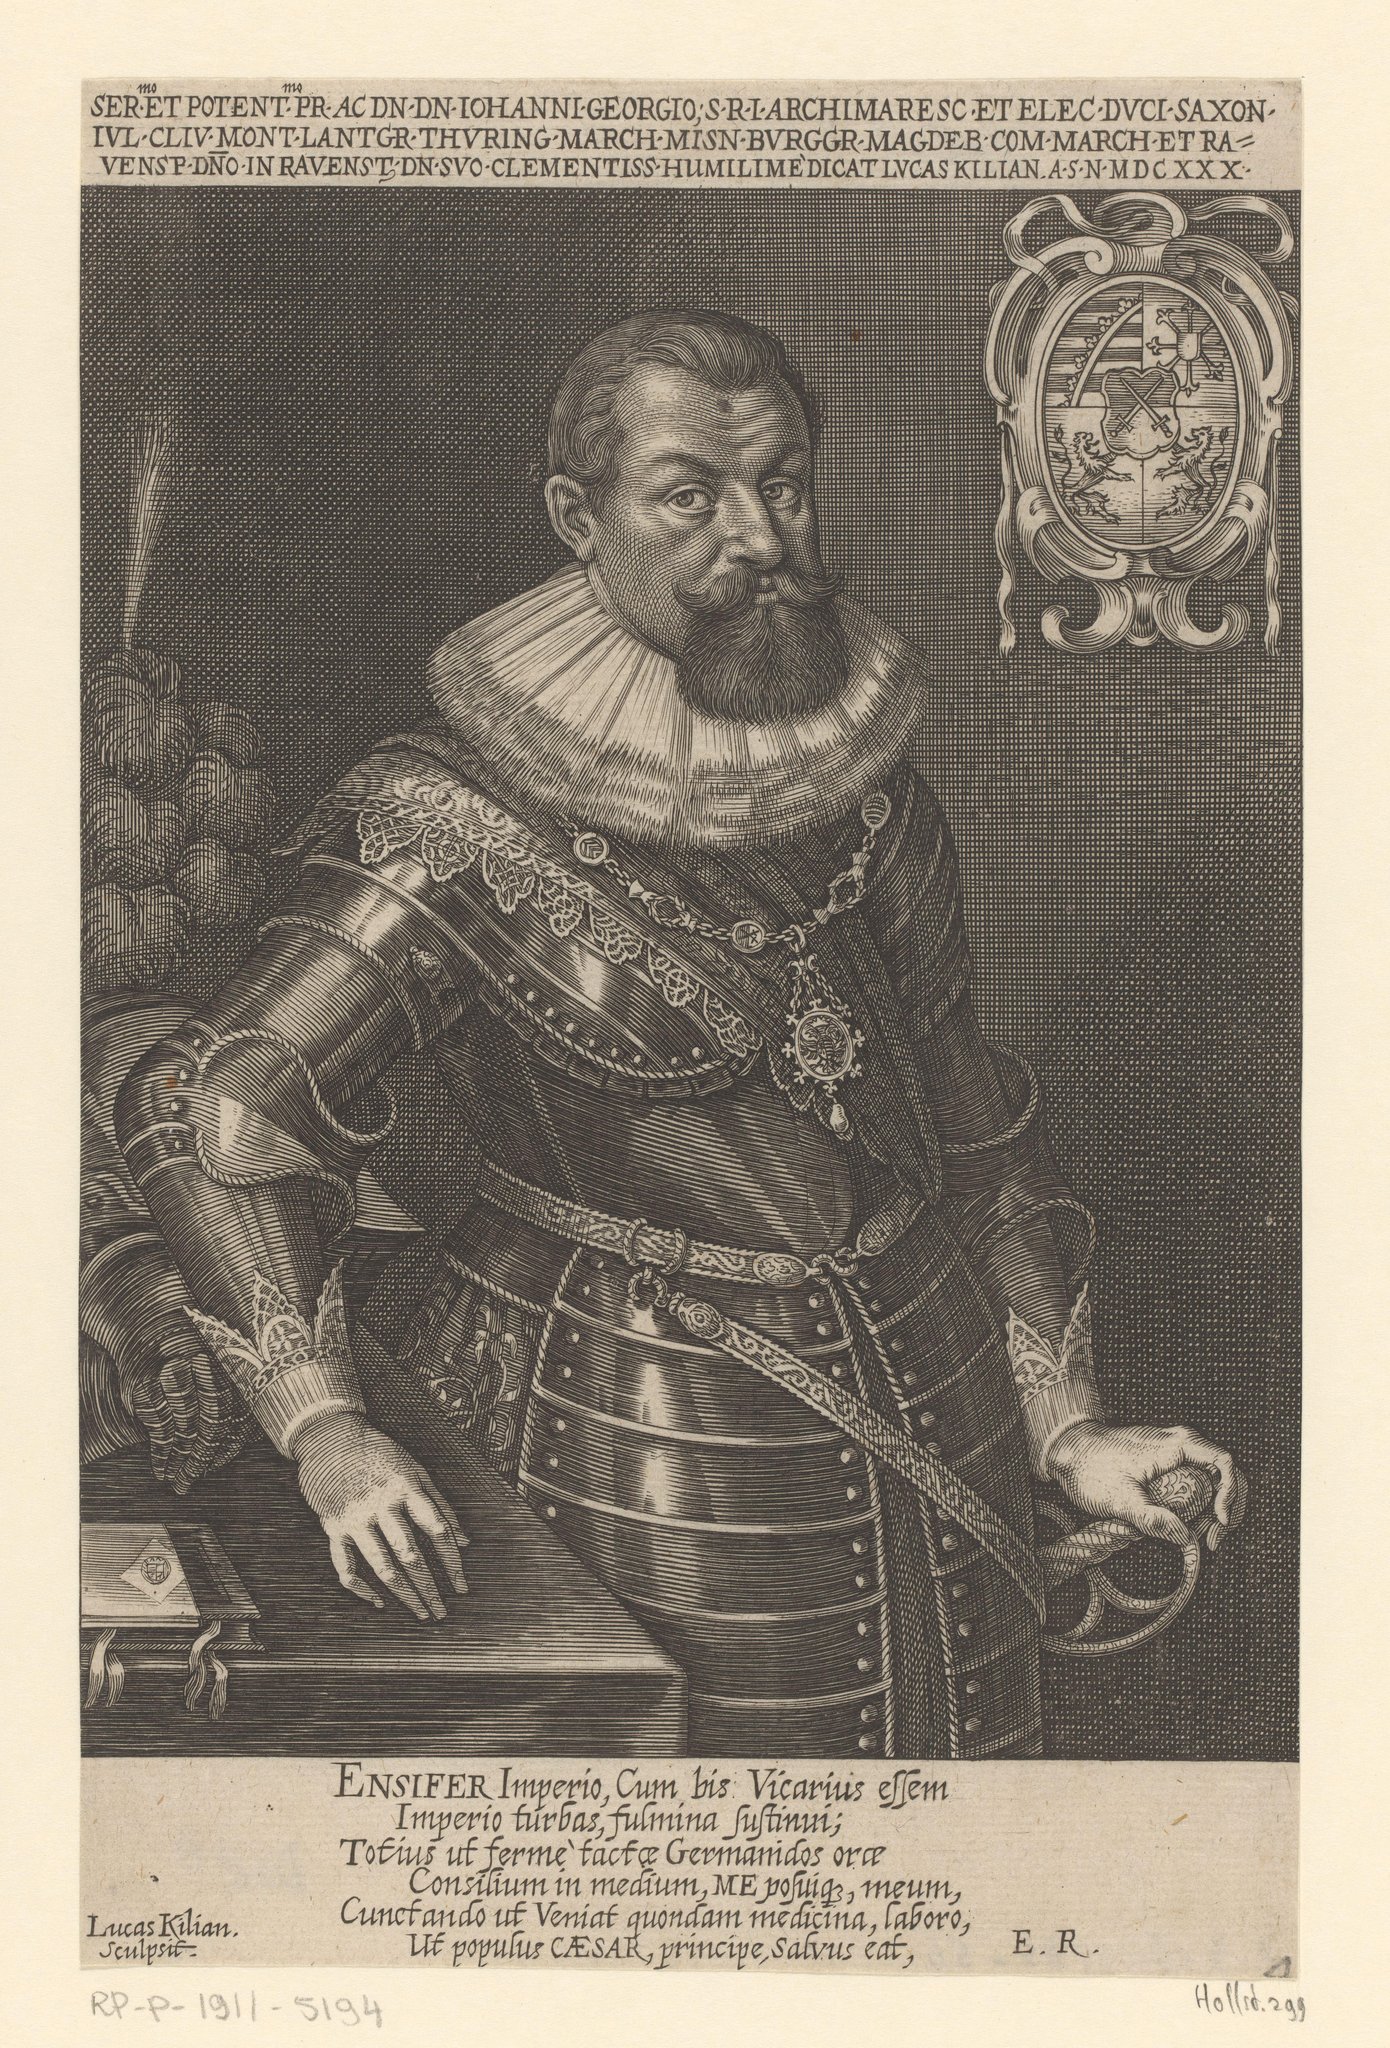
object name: print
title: Portret van Johann Georg van Saksen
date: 1630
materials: paper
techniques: engraving, etching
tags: johann george van saksen (i), armour, historical persons, ruler, sovereign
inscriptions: collector's mark: Lugt 2228